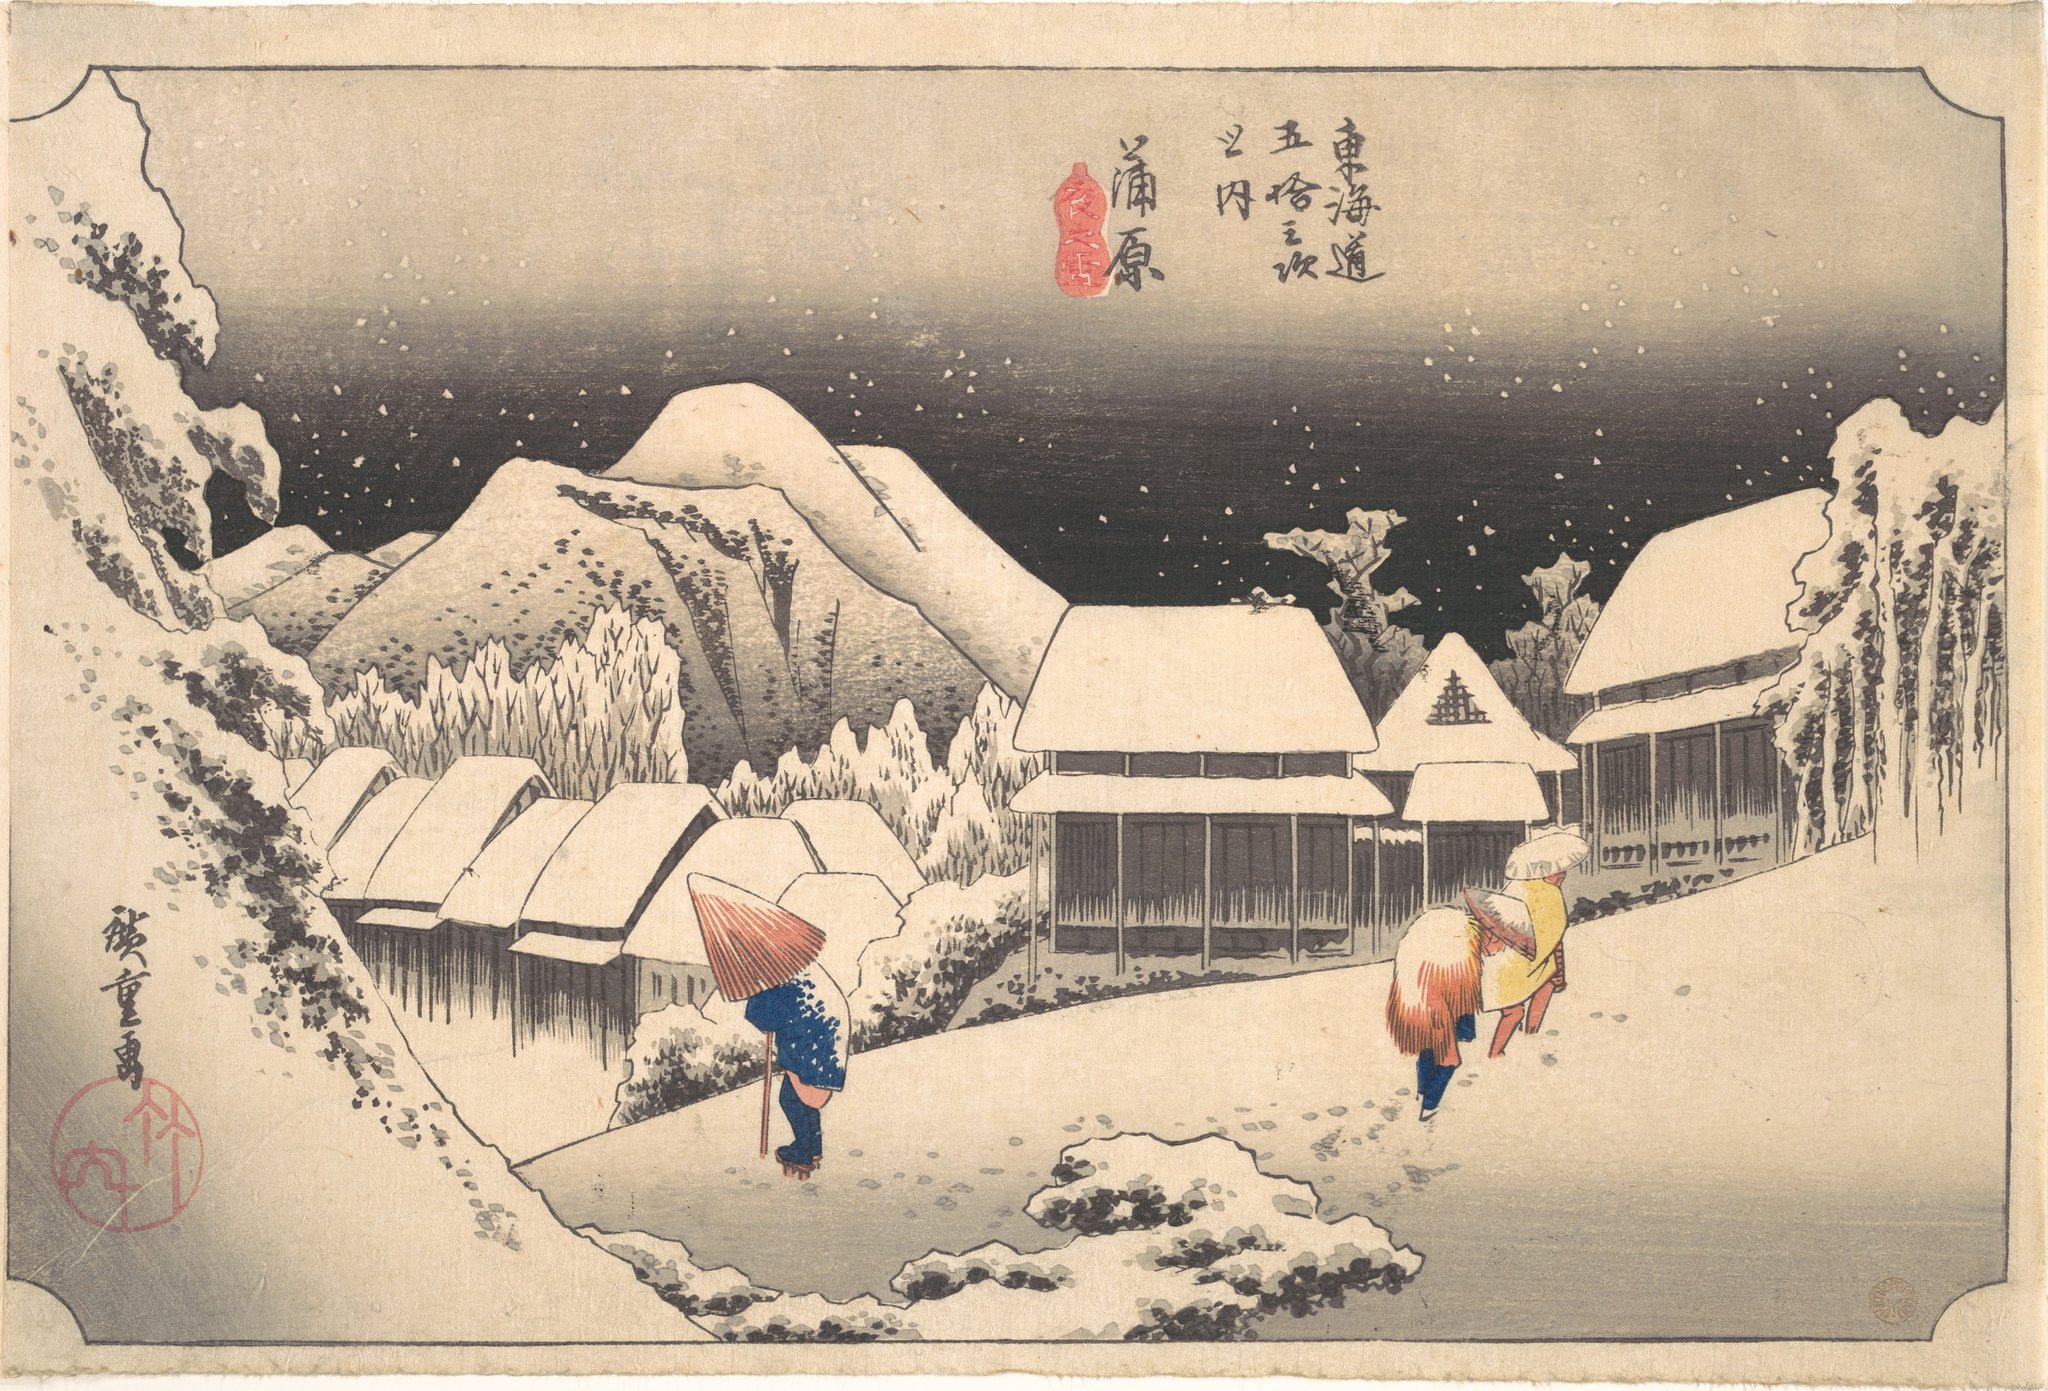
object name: woodblock print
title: A Snowy Evening at Kanbara Station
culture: japanese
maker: utagawa hiroshige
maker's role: artist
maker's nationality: japanese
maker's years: 1797-1858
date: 1833-1834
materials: ink, paper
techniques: woodblock print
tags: houses,mountains,snow